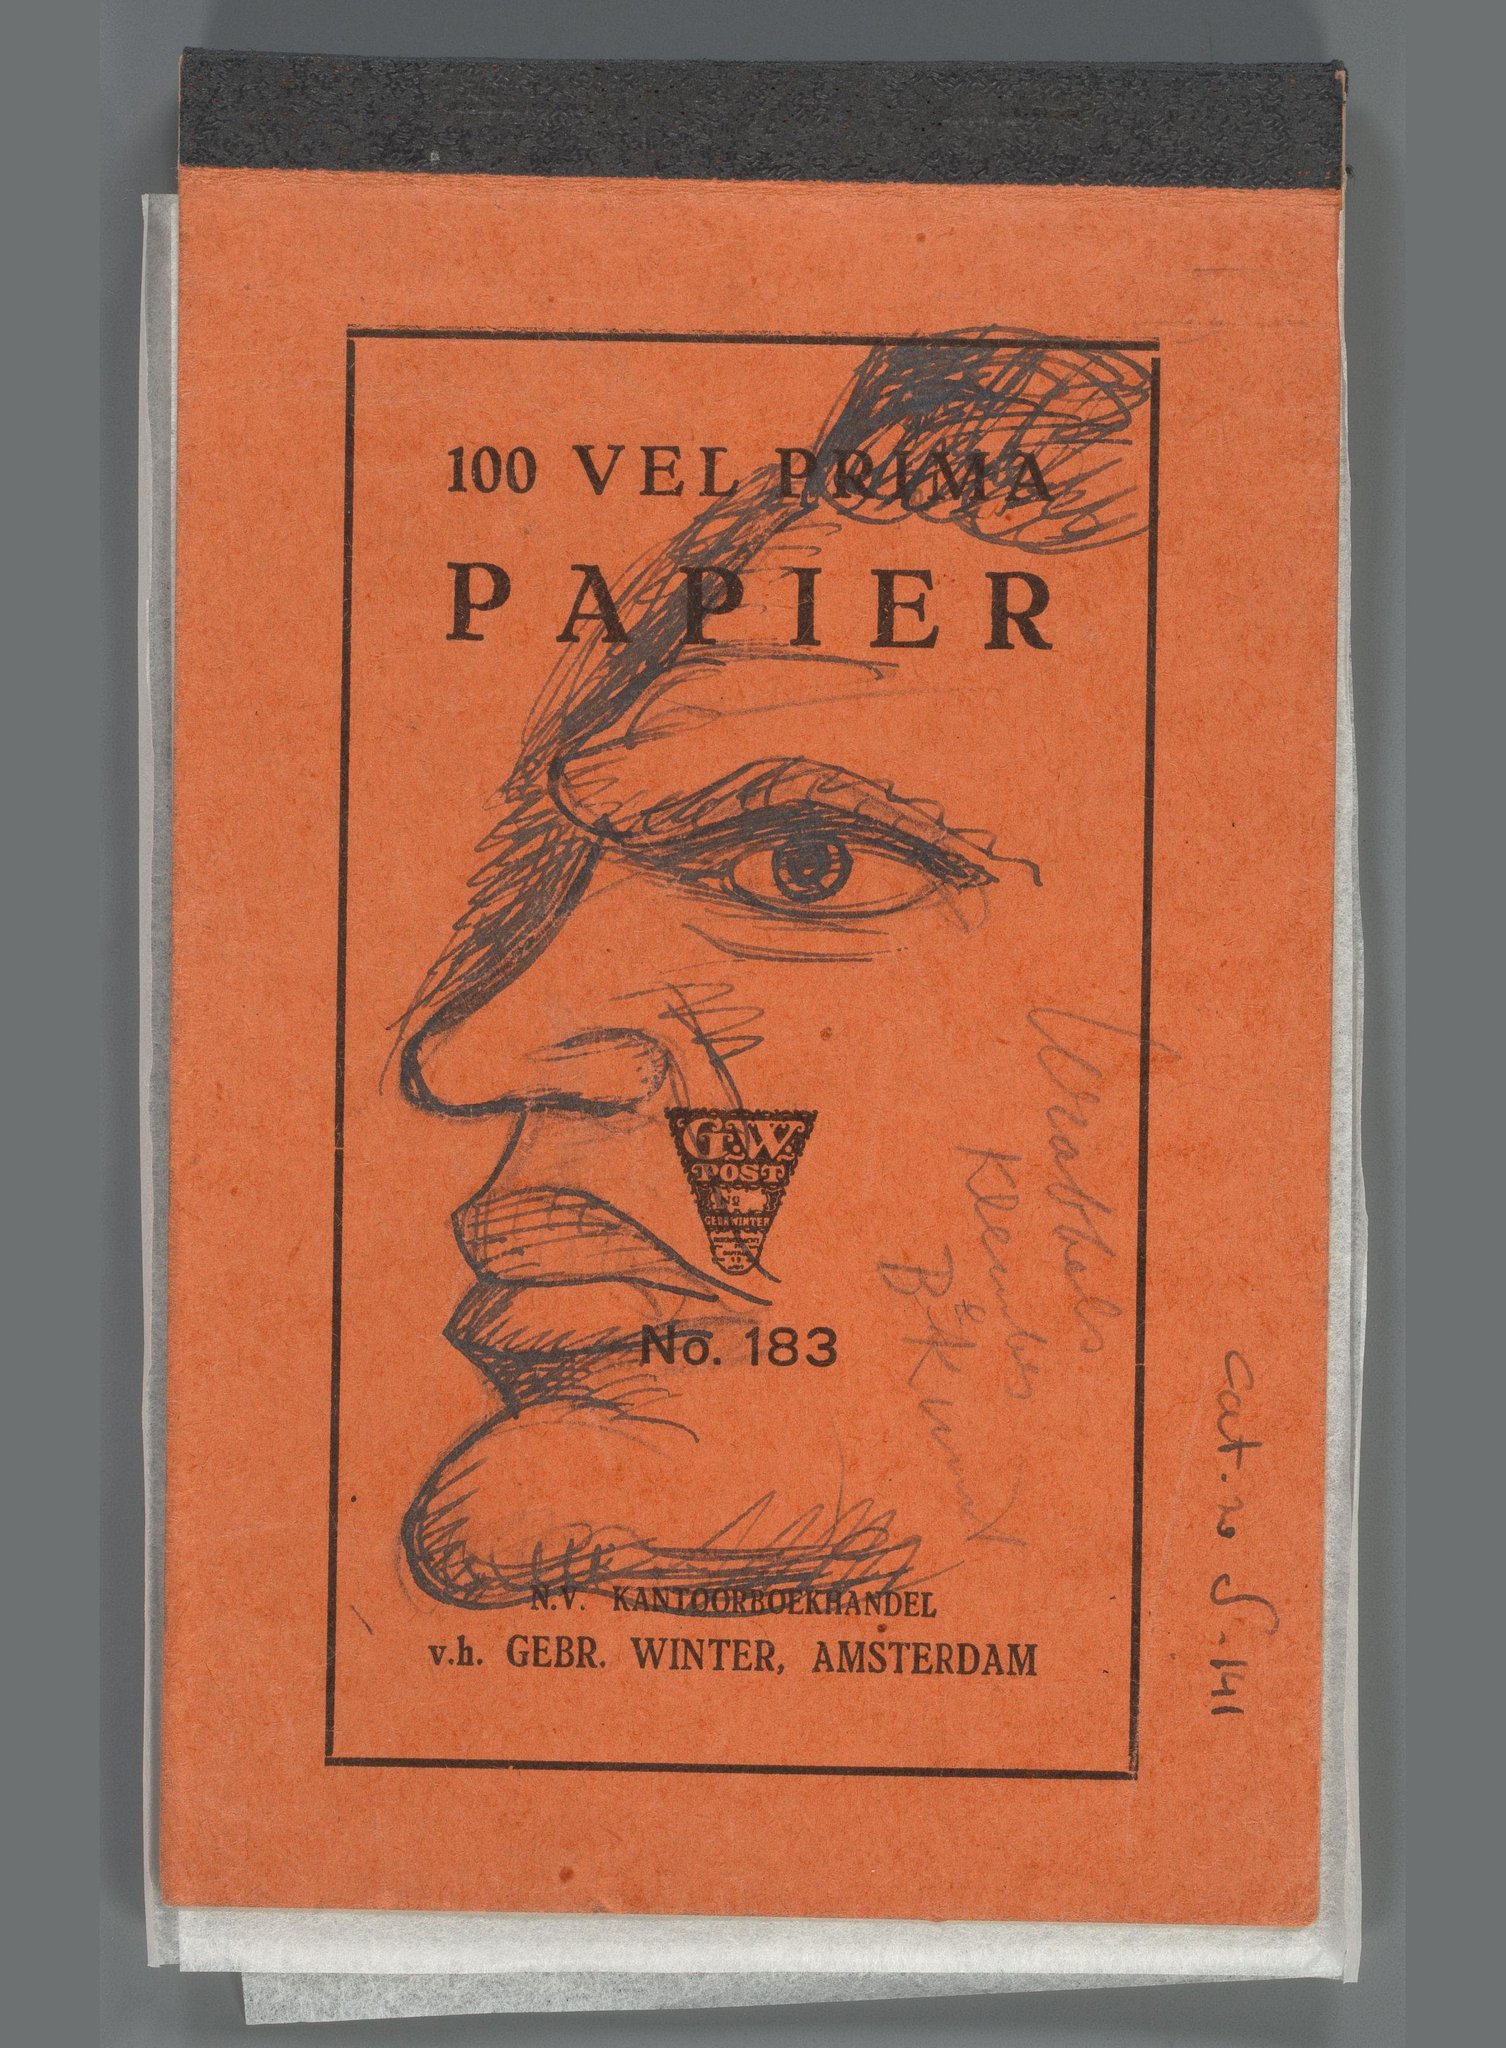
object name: sketchbook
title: Schetsboek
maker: leo gestel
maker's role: draughtsman, print maker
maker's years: 1881-1941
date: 1939-1941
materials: ink, paper, pencil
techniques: brush, drawing, pen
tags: dragon, horse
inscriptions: workshop stamp: Lugt 1078a, inscription: ‘schetsboek/ 14 teekeningen’, title: ‘Krabbels [?]’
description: Schetsboek met schetsen van paarden, koppen, een draak en Sint Joris en de draak.